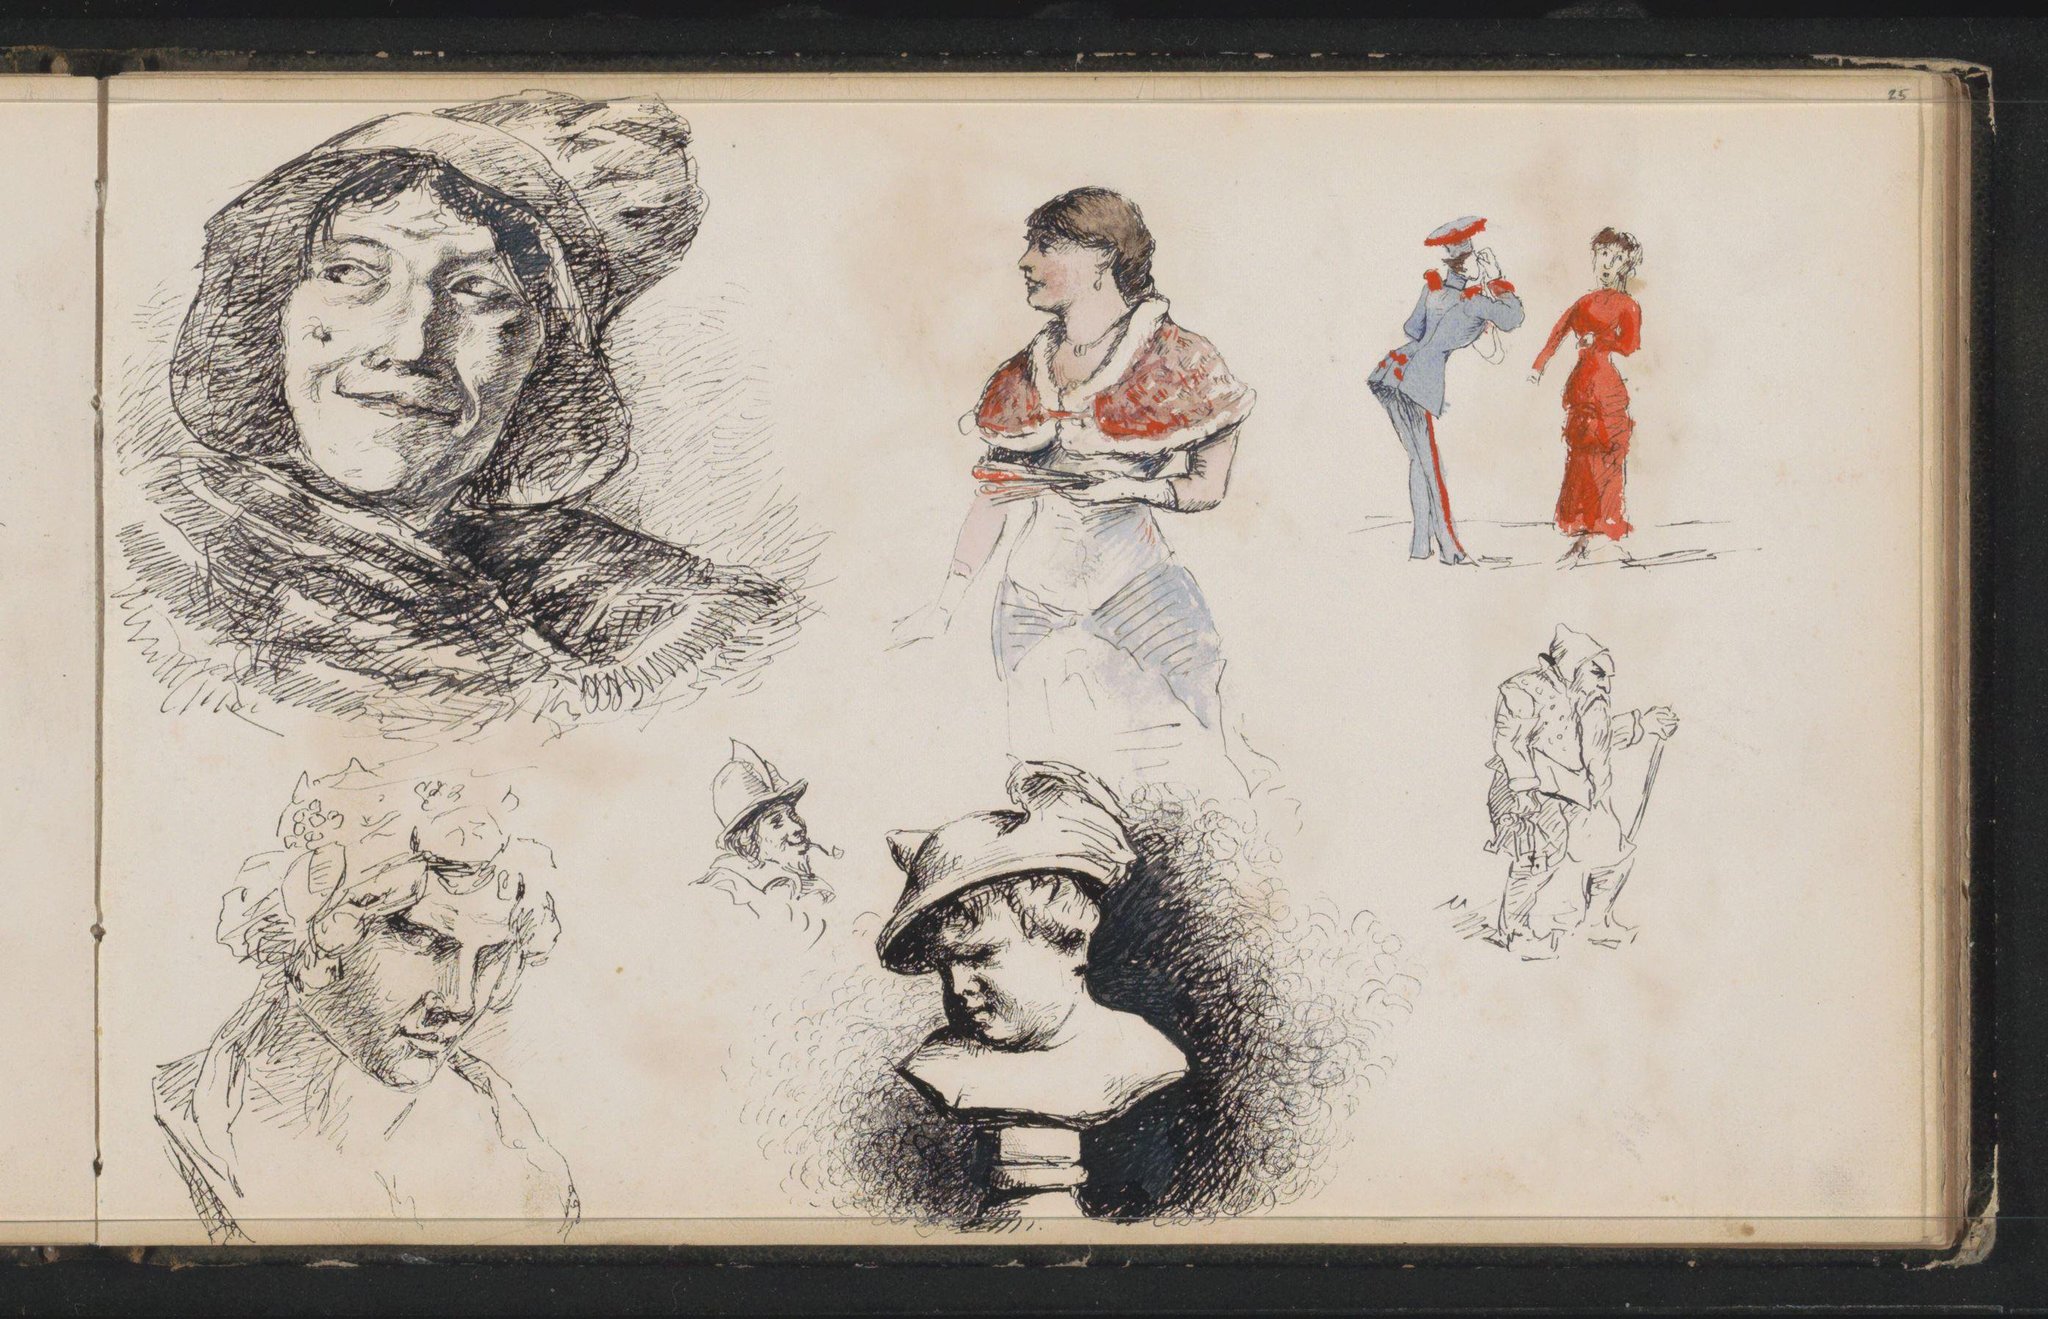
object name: sketchbook leaf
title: Kopieën naar Michelangelo en Frans Hals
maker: marius bauer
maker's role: draughtsman, print maker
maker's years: 1867-1932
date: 1812-1880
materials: paper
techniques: pen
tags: head (human), adult woman, sculpture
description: Kopie van de 'Bacchus' van Michelangelo, vrije kopie naar 'De luitspeler' van Frans Hals en een mogelijke kopie naar een onbekend beeldhouwwerk. Tevens een karikatuur en studies van een vrouw in een roodfluwelen huisjasje dat met bont is afgezet en van een dwerg met een sleutelbos. Pagina 25 uit een schetsboek met 34 bladen.